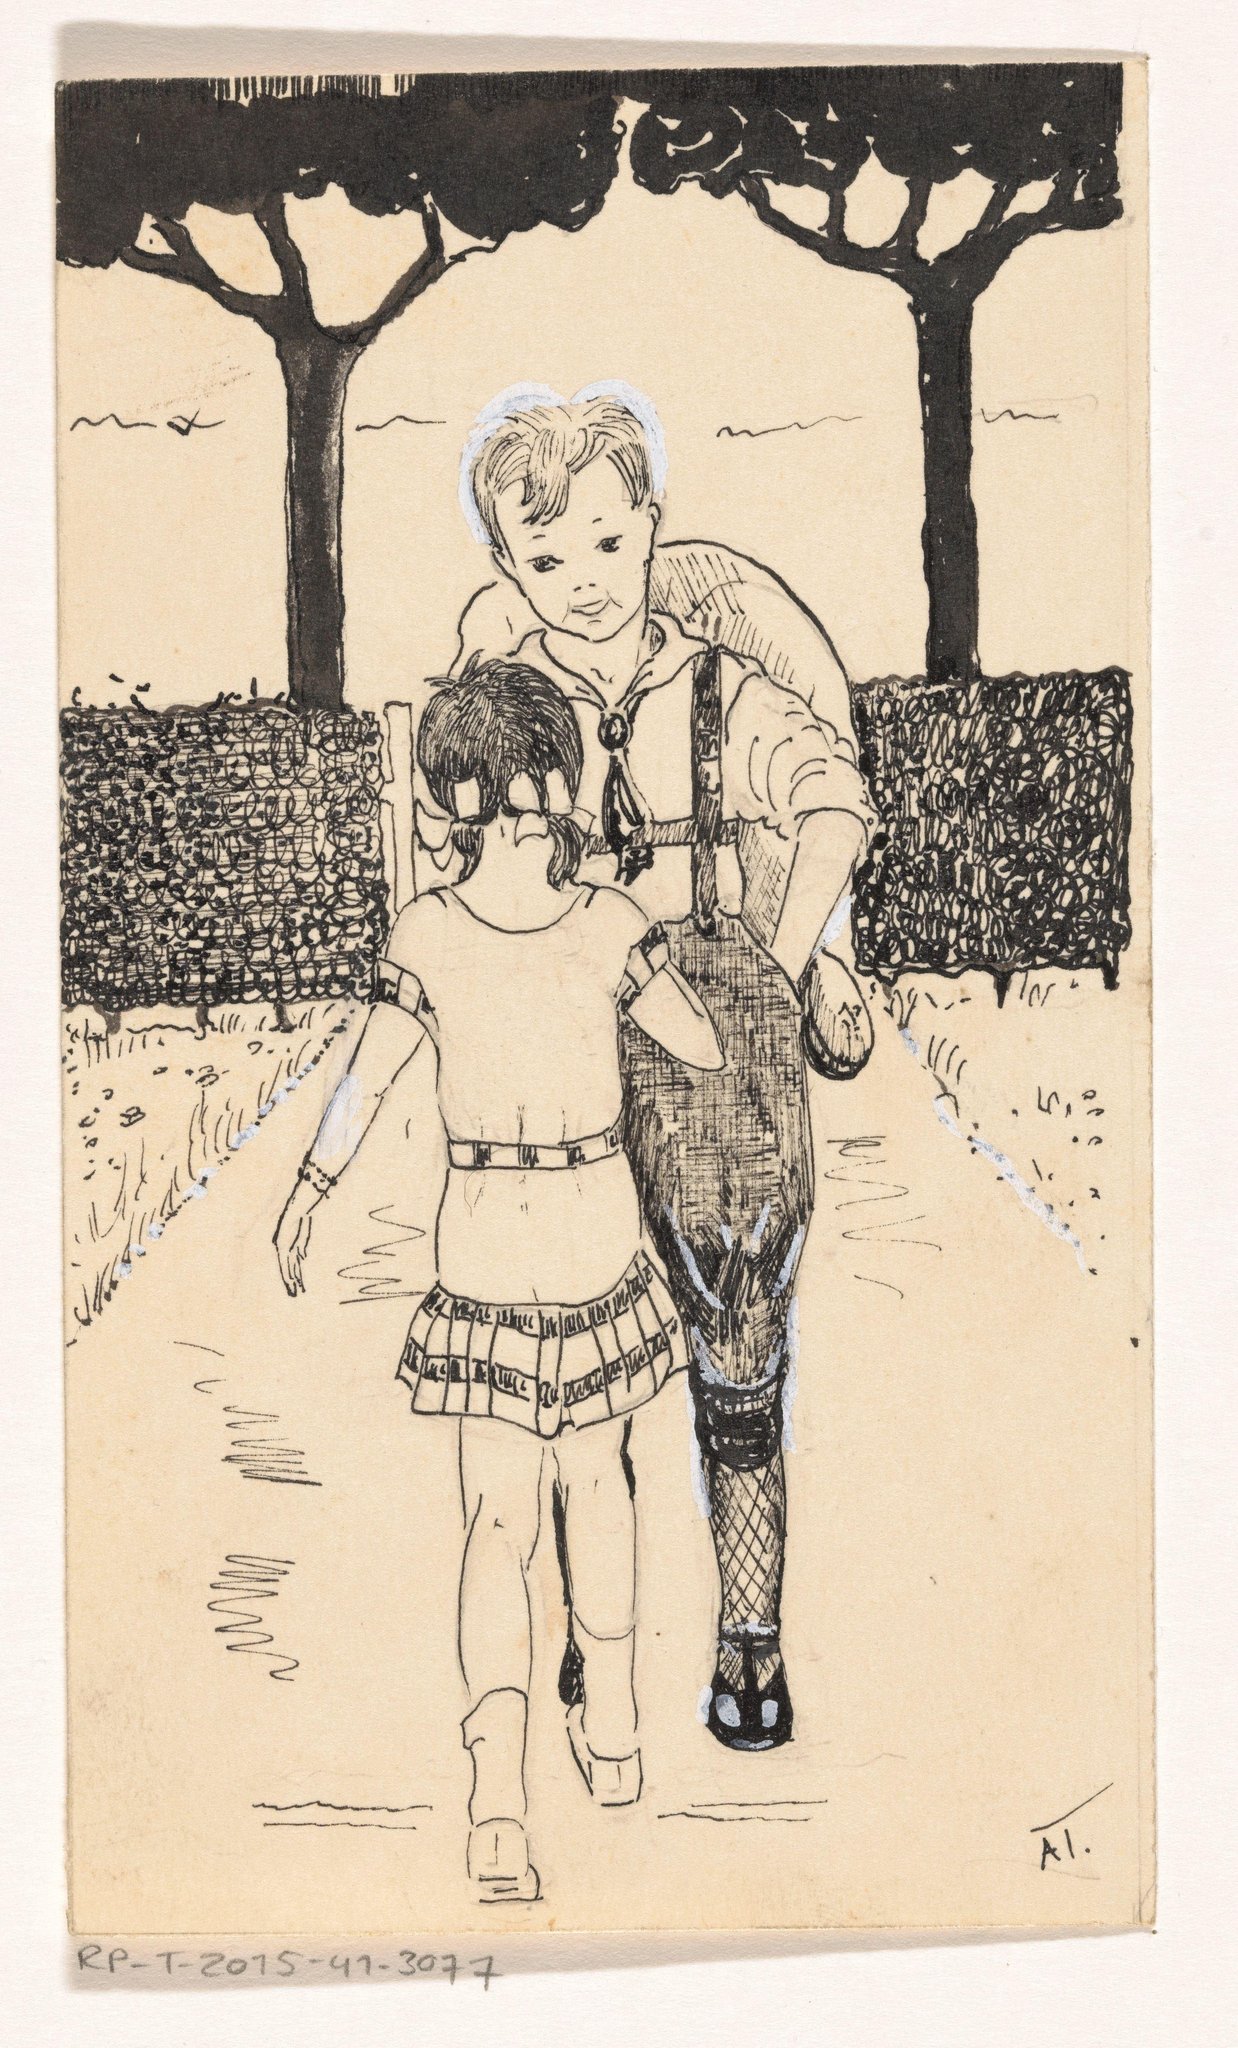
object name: drawing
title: Jongen en meisje op een tuinpad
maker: a. tinbergen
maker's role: draughtsman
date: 1925-1935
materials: paint, ink, paper, pencil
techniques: brush, pen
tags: hand in the pocket, shrubs, child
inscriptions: :, collector's mark: Lugt 2228a, monogram: ‘AT.’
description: Een jongen en meisje staan tegenover elkaar op een tuinpad. De jongen heeft de handen in de zakken gestoken. In de achtergrond een haag en twee bomen.